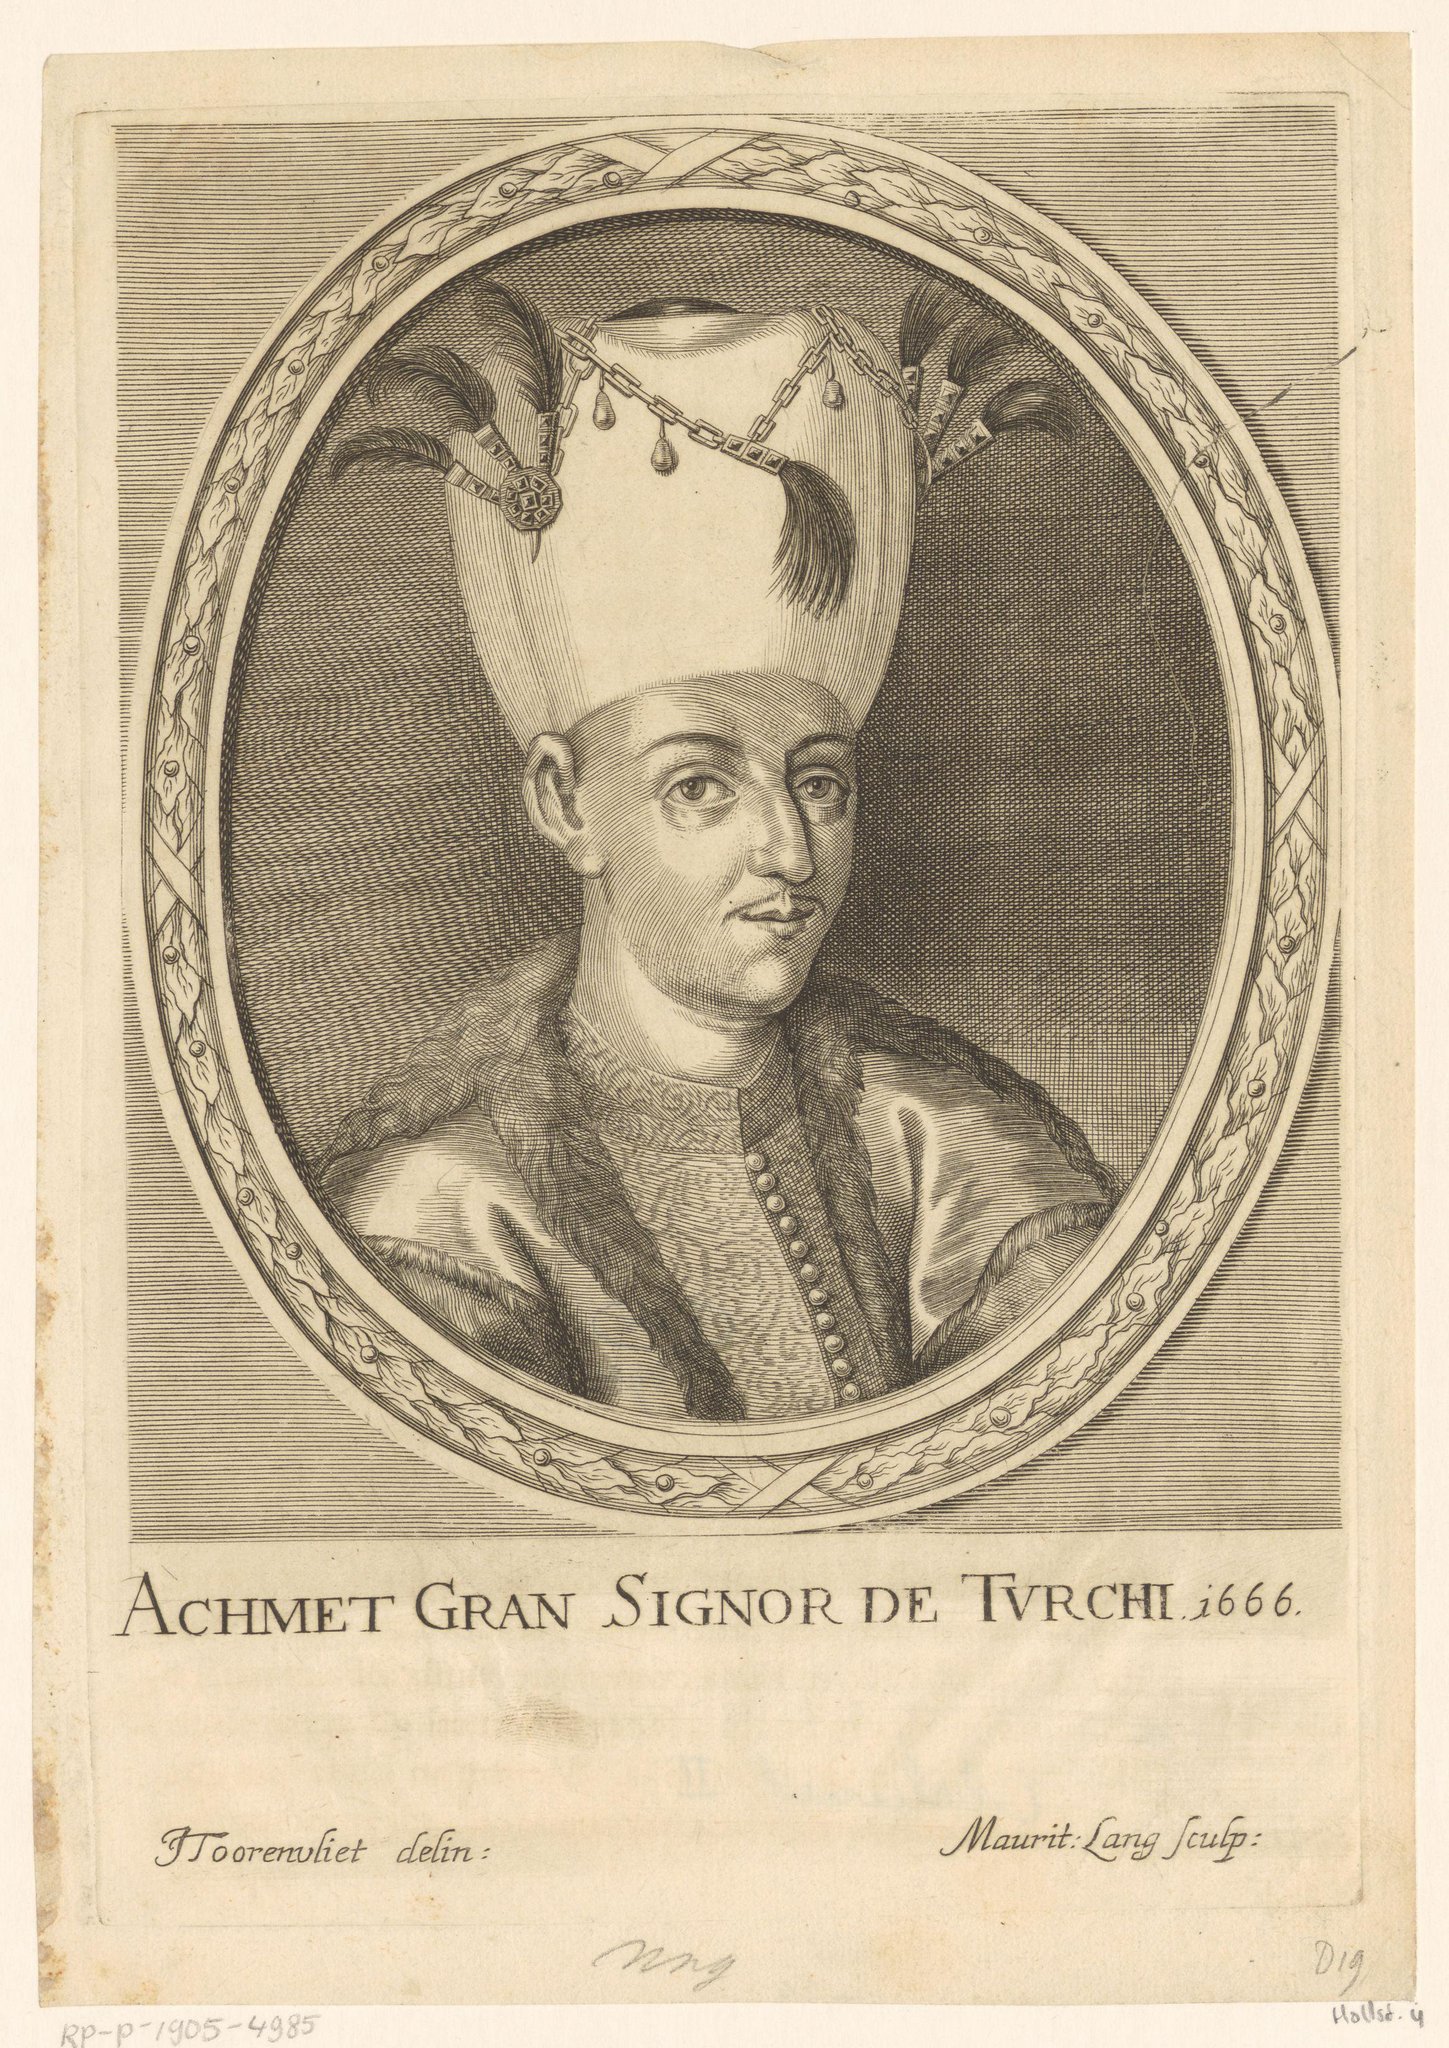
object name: print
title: Portret van Köprülü Fazil Ahmet Pasja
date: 1661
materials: paper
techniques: engraving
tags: historical persons, politician, e.g. party leader, ruler, sovereign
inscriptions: collector's mark: Lugt 2228